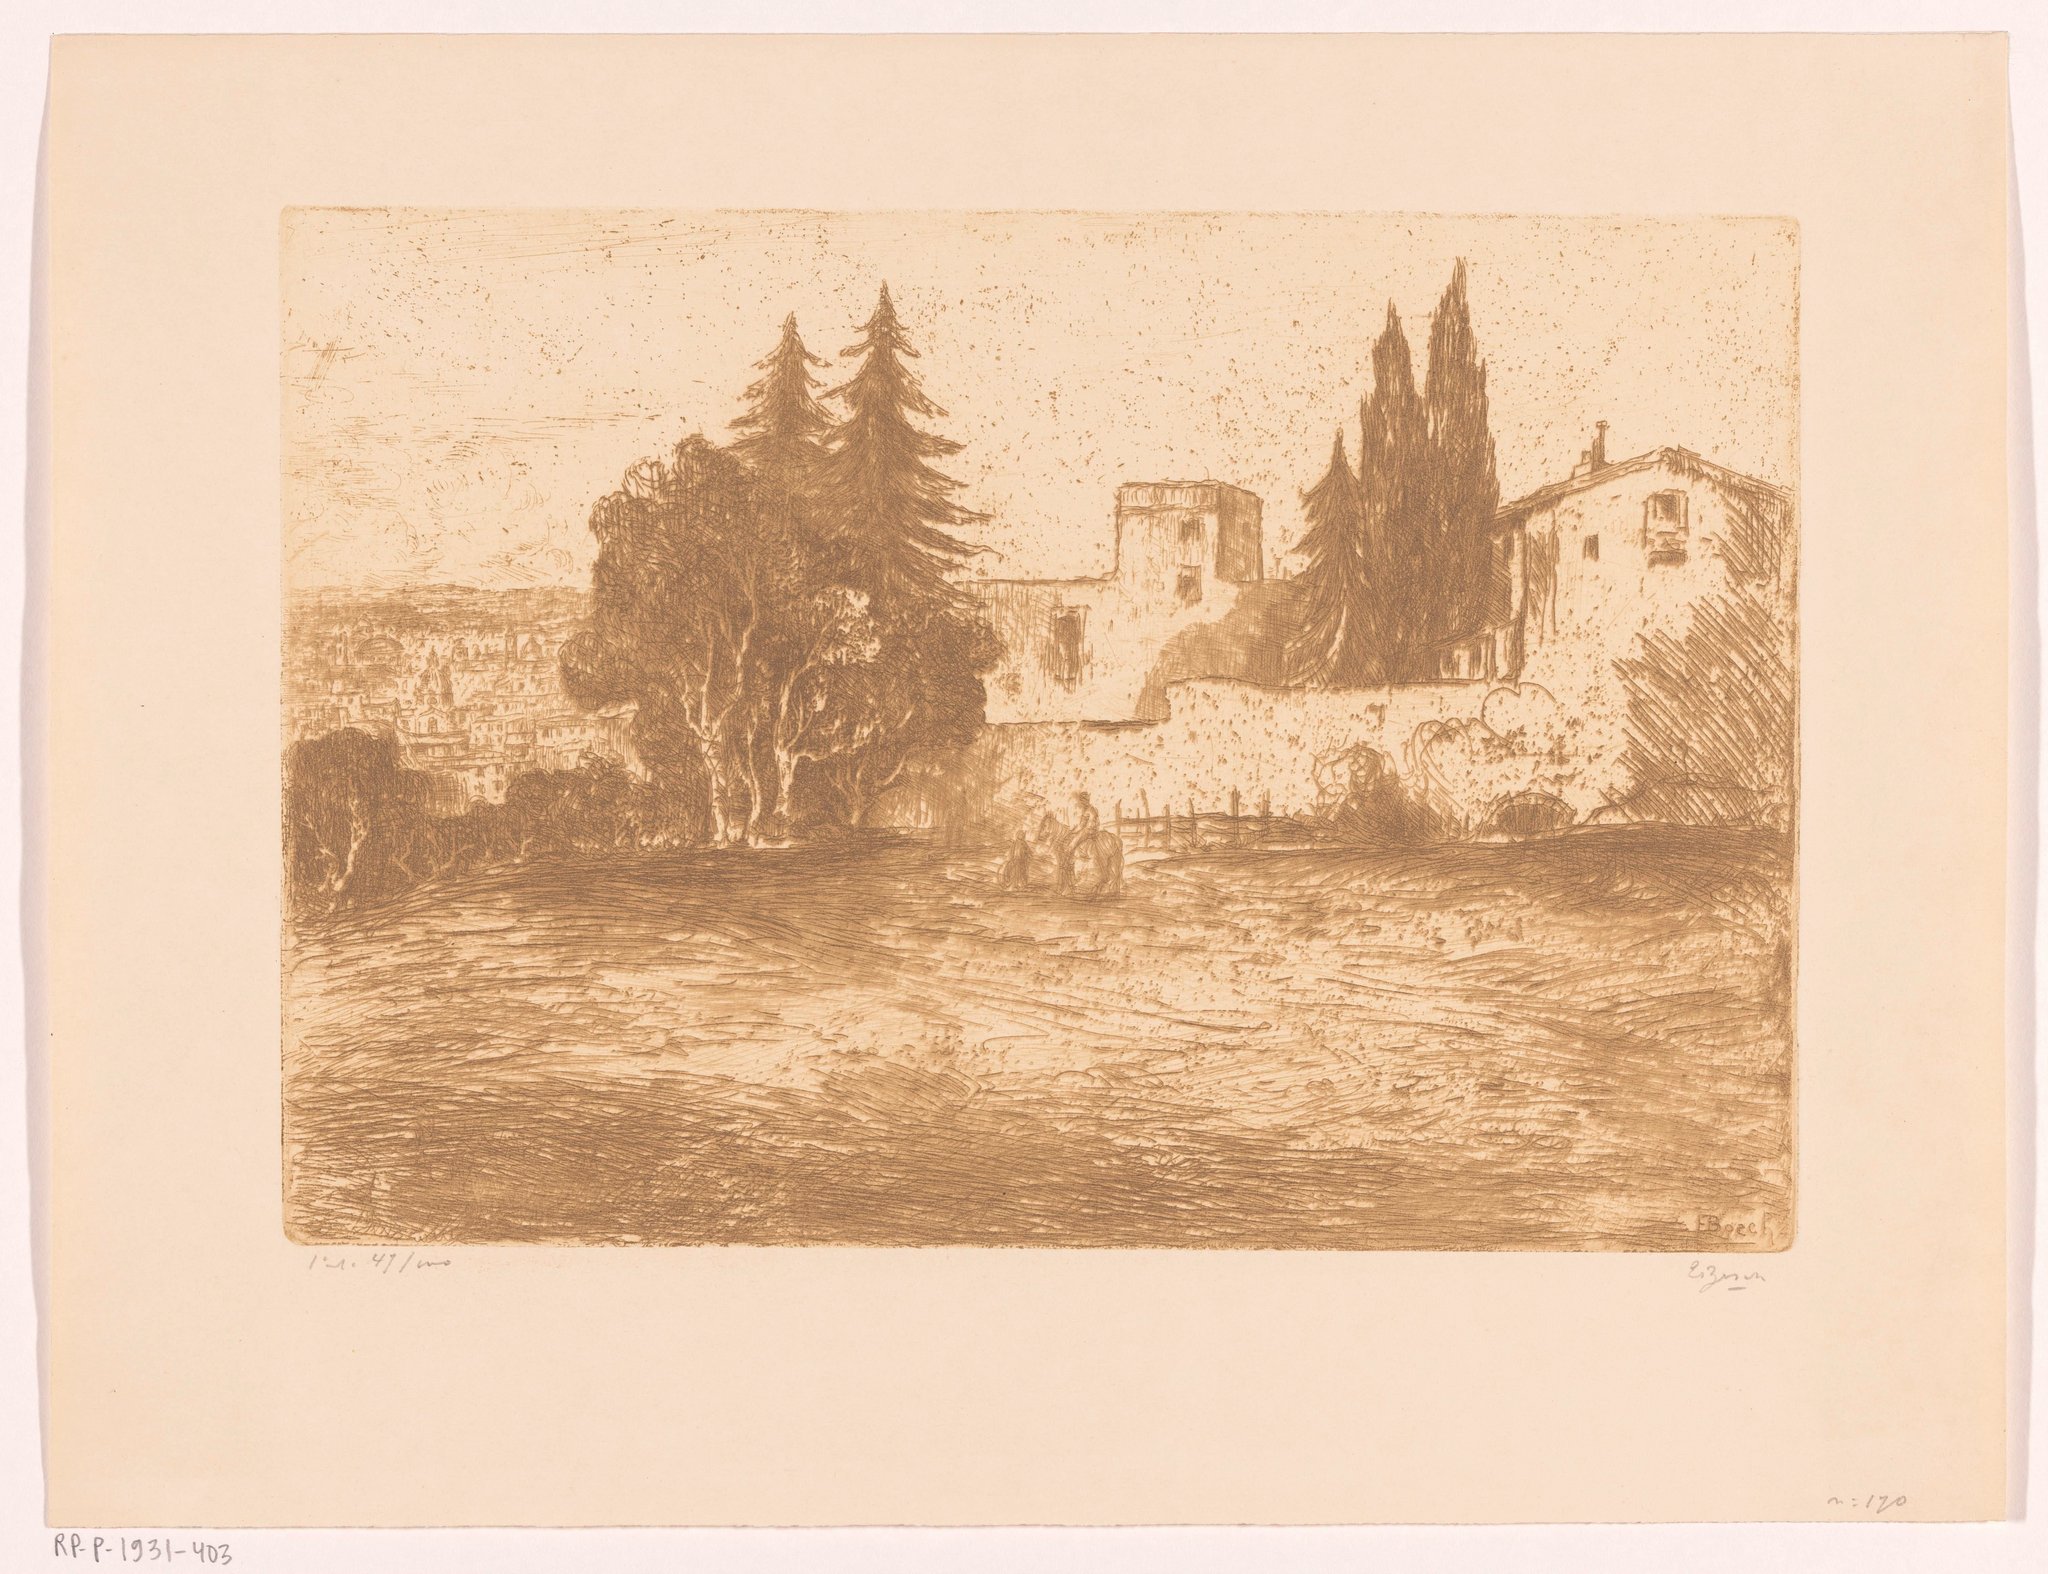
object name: print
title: Landschap bij Rome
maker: etienne bosch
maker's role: print maker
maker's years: 1863-1933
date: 1873-1931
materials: paper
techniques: etching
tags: city-view, and landscape with man-made constructions, low hill country, rome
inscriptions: collector's mark: Lugt 2228, number: ‘no. 170’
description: Huizen en bomen op een heuvel. Links op de achtergrond zicht op de stad Rome.